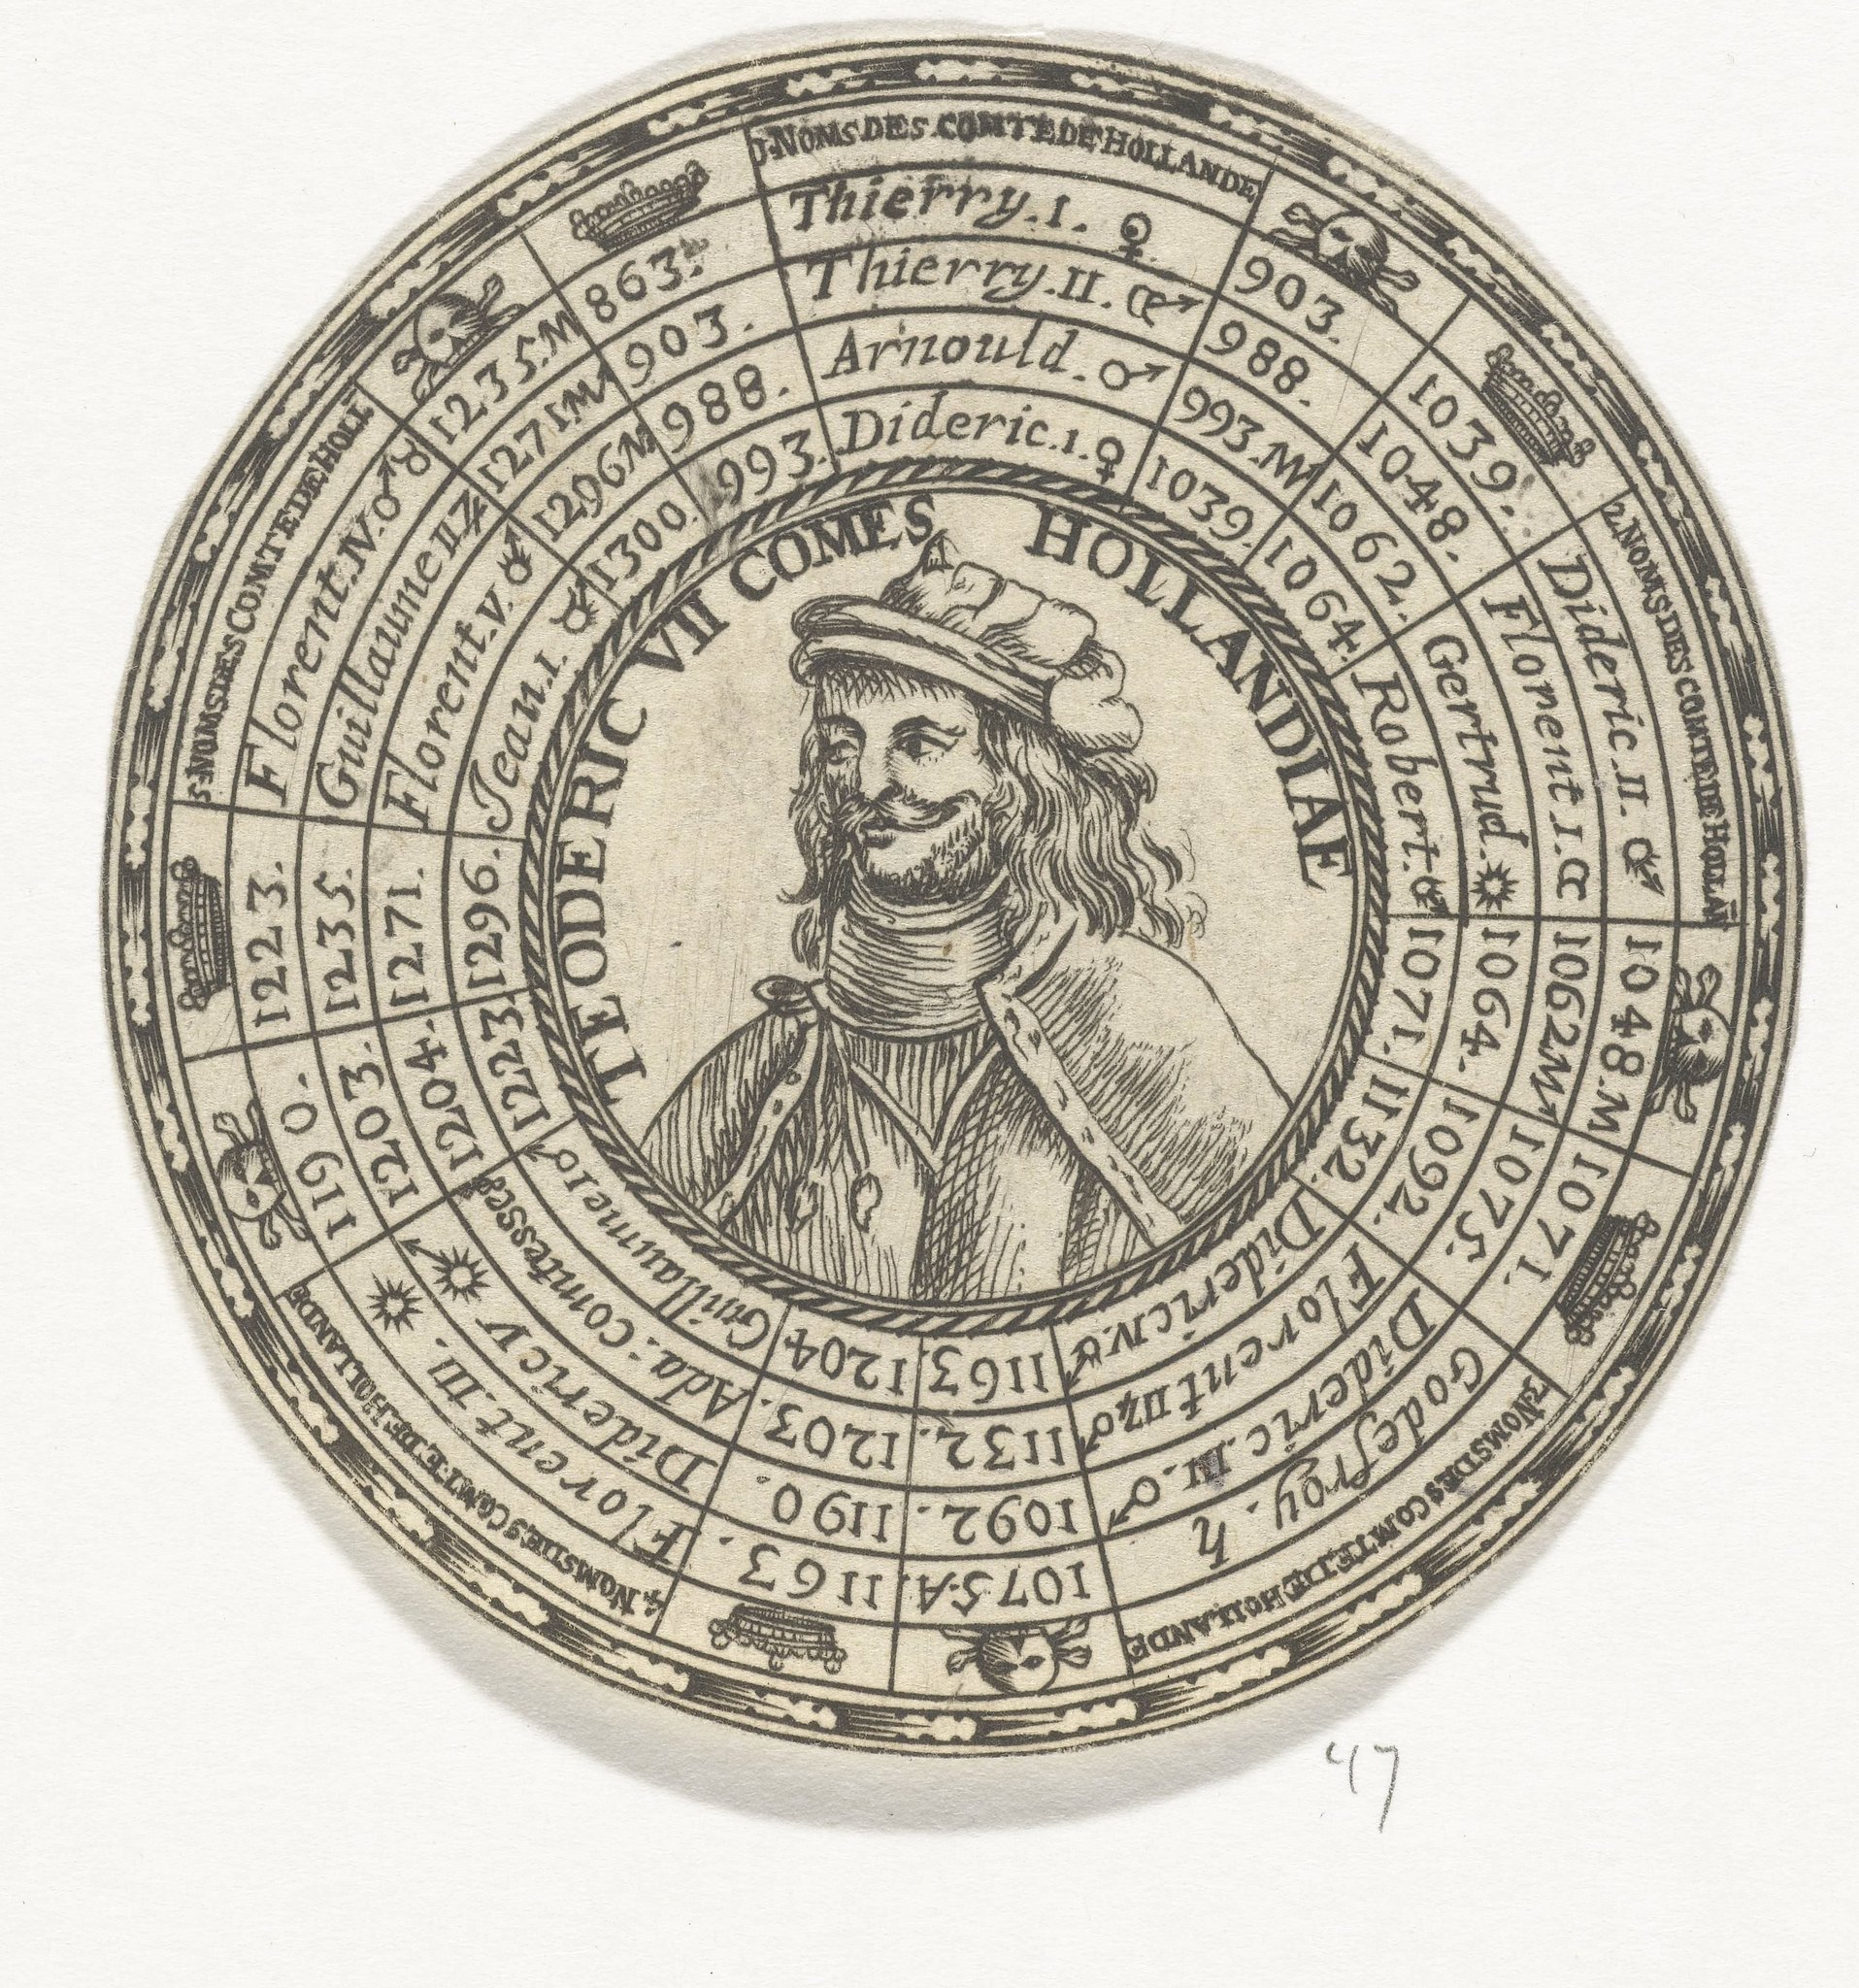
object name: print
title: Penning met het portret van Dirk VII en de namen van de graven van Holland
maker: Anonymous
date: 1685-1720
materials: paper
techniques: etching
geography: amsterdam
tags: dordrecht, feudal lord, seal (symbol of sovereignty)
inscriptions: number: ‘49’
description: Ontwerp van een ronde penning met, in vijf concentrische cirkels, de namen van de graven van Holland en hun regeringsjaren, beginnende bij graaf Dirk I en eindigend bij Jan I van Holland. In het midden van de penning het portret van graaf Dirk VII van Holland.